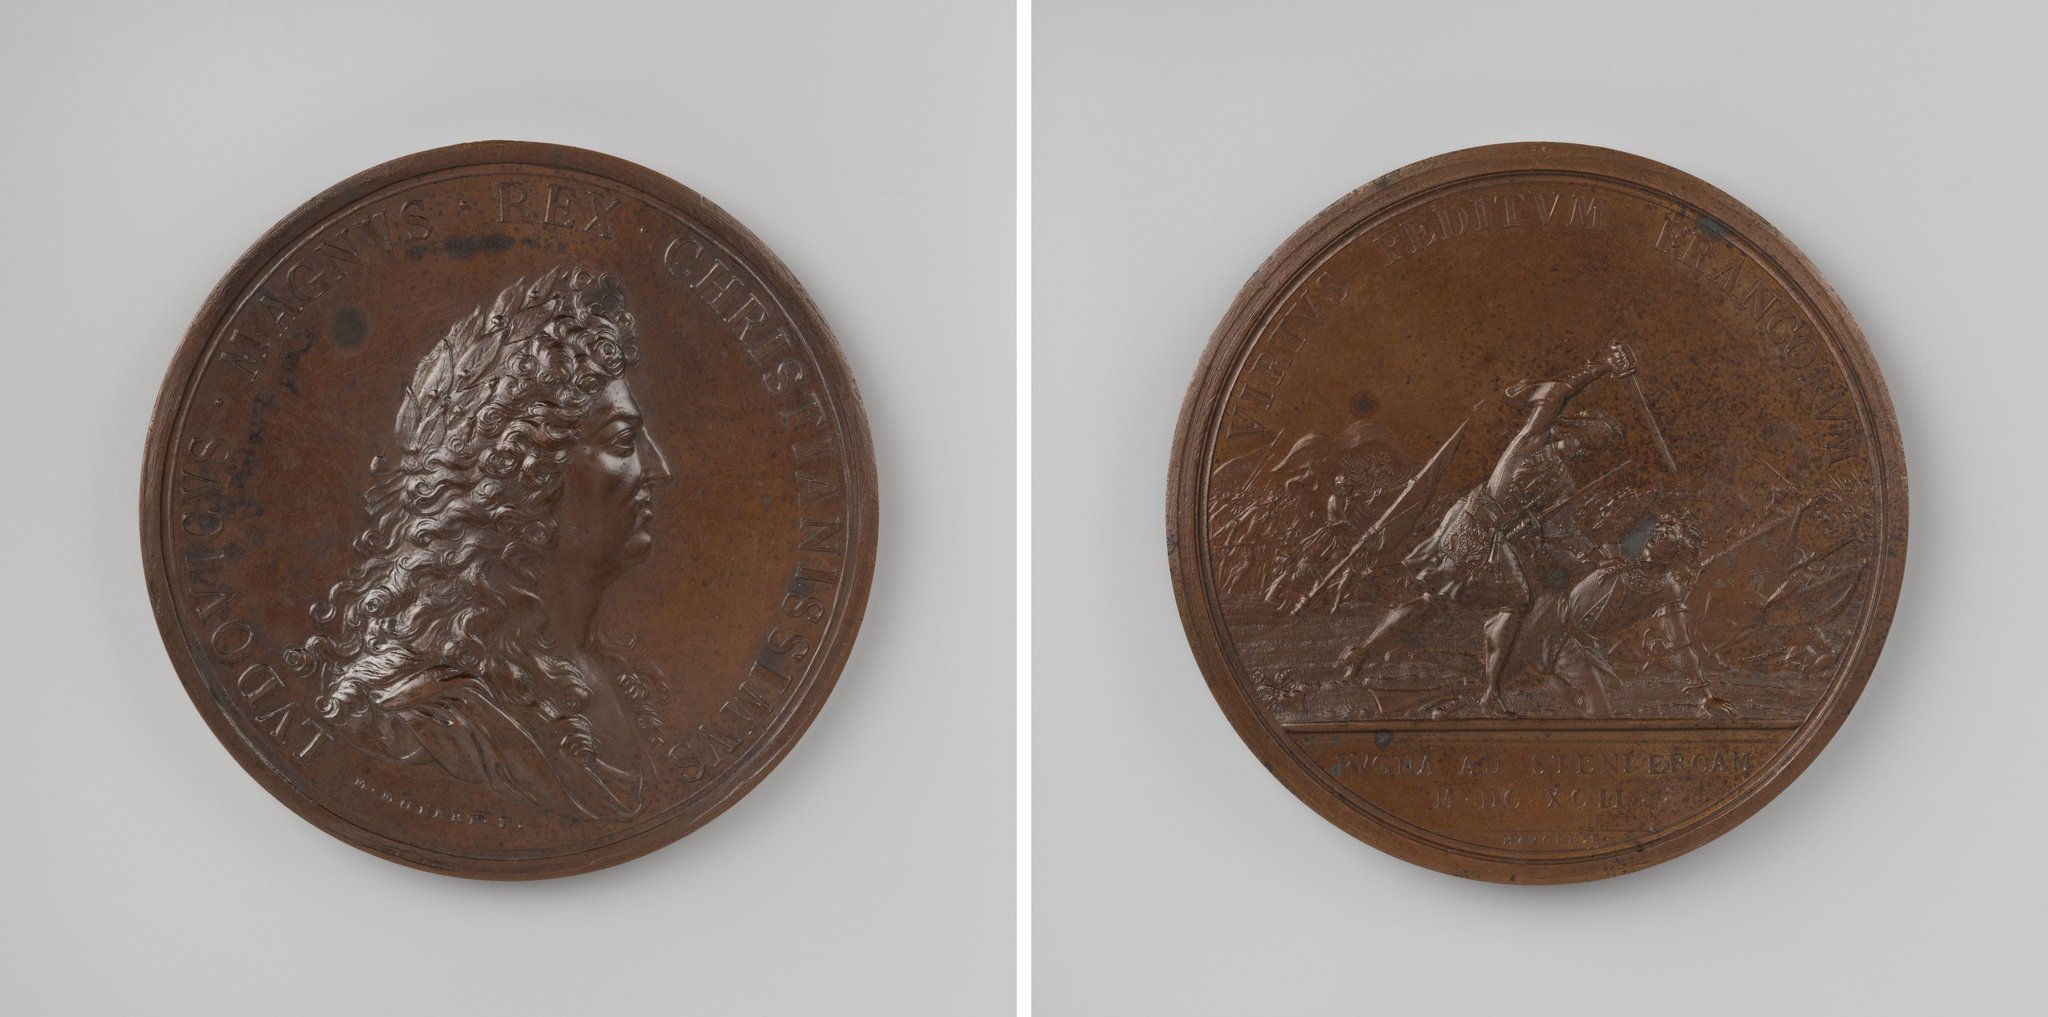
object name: history medal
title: Slag bij Steenkerken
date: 1692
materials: bronze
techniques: striking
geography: paris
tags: lodewijk xiv (koning van frankrijk), henegouwen